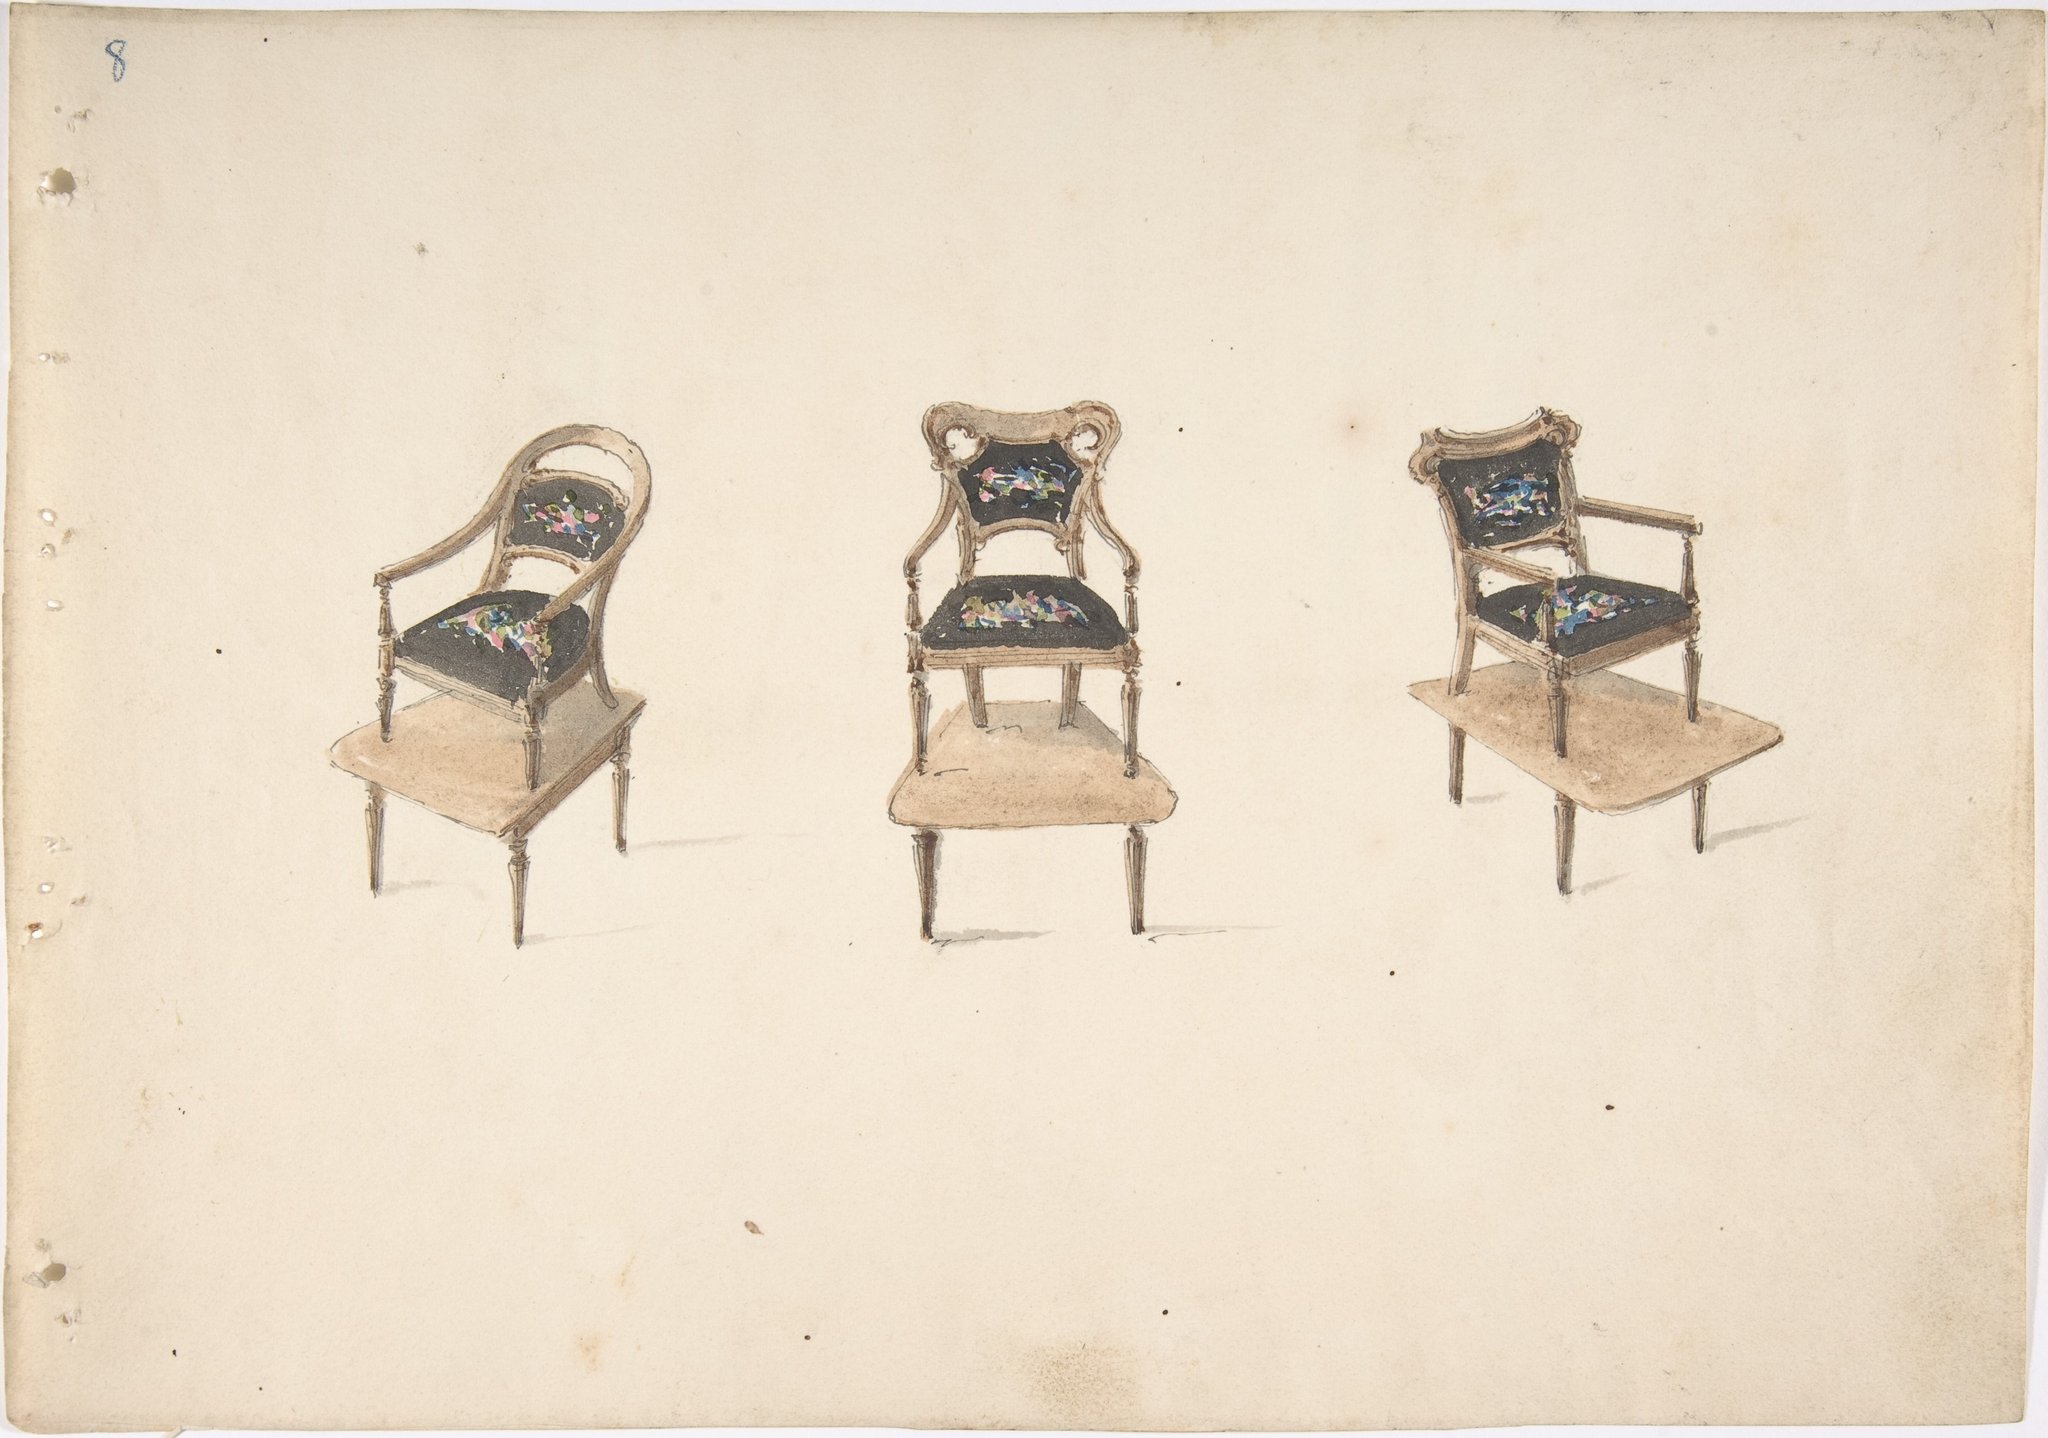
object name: drawing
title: Design for Three Small Elevated Armchairs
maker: anonymous, british, 19th century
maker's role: artist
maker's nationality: british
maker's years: 1800-1900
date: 1801-1833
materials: ink, watercolor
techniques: brush, pen, wash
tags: chairs